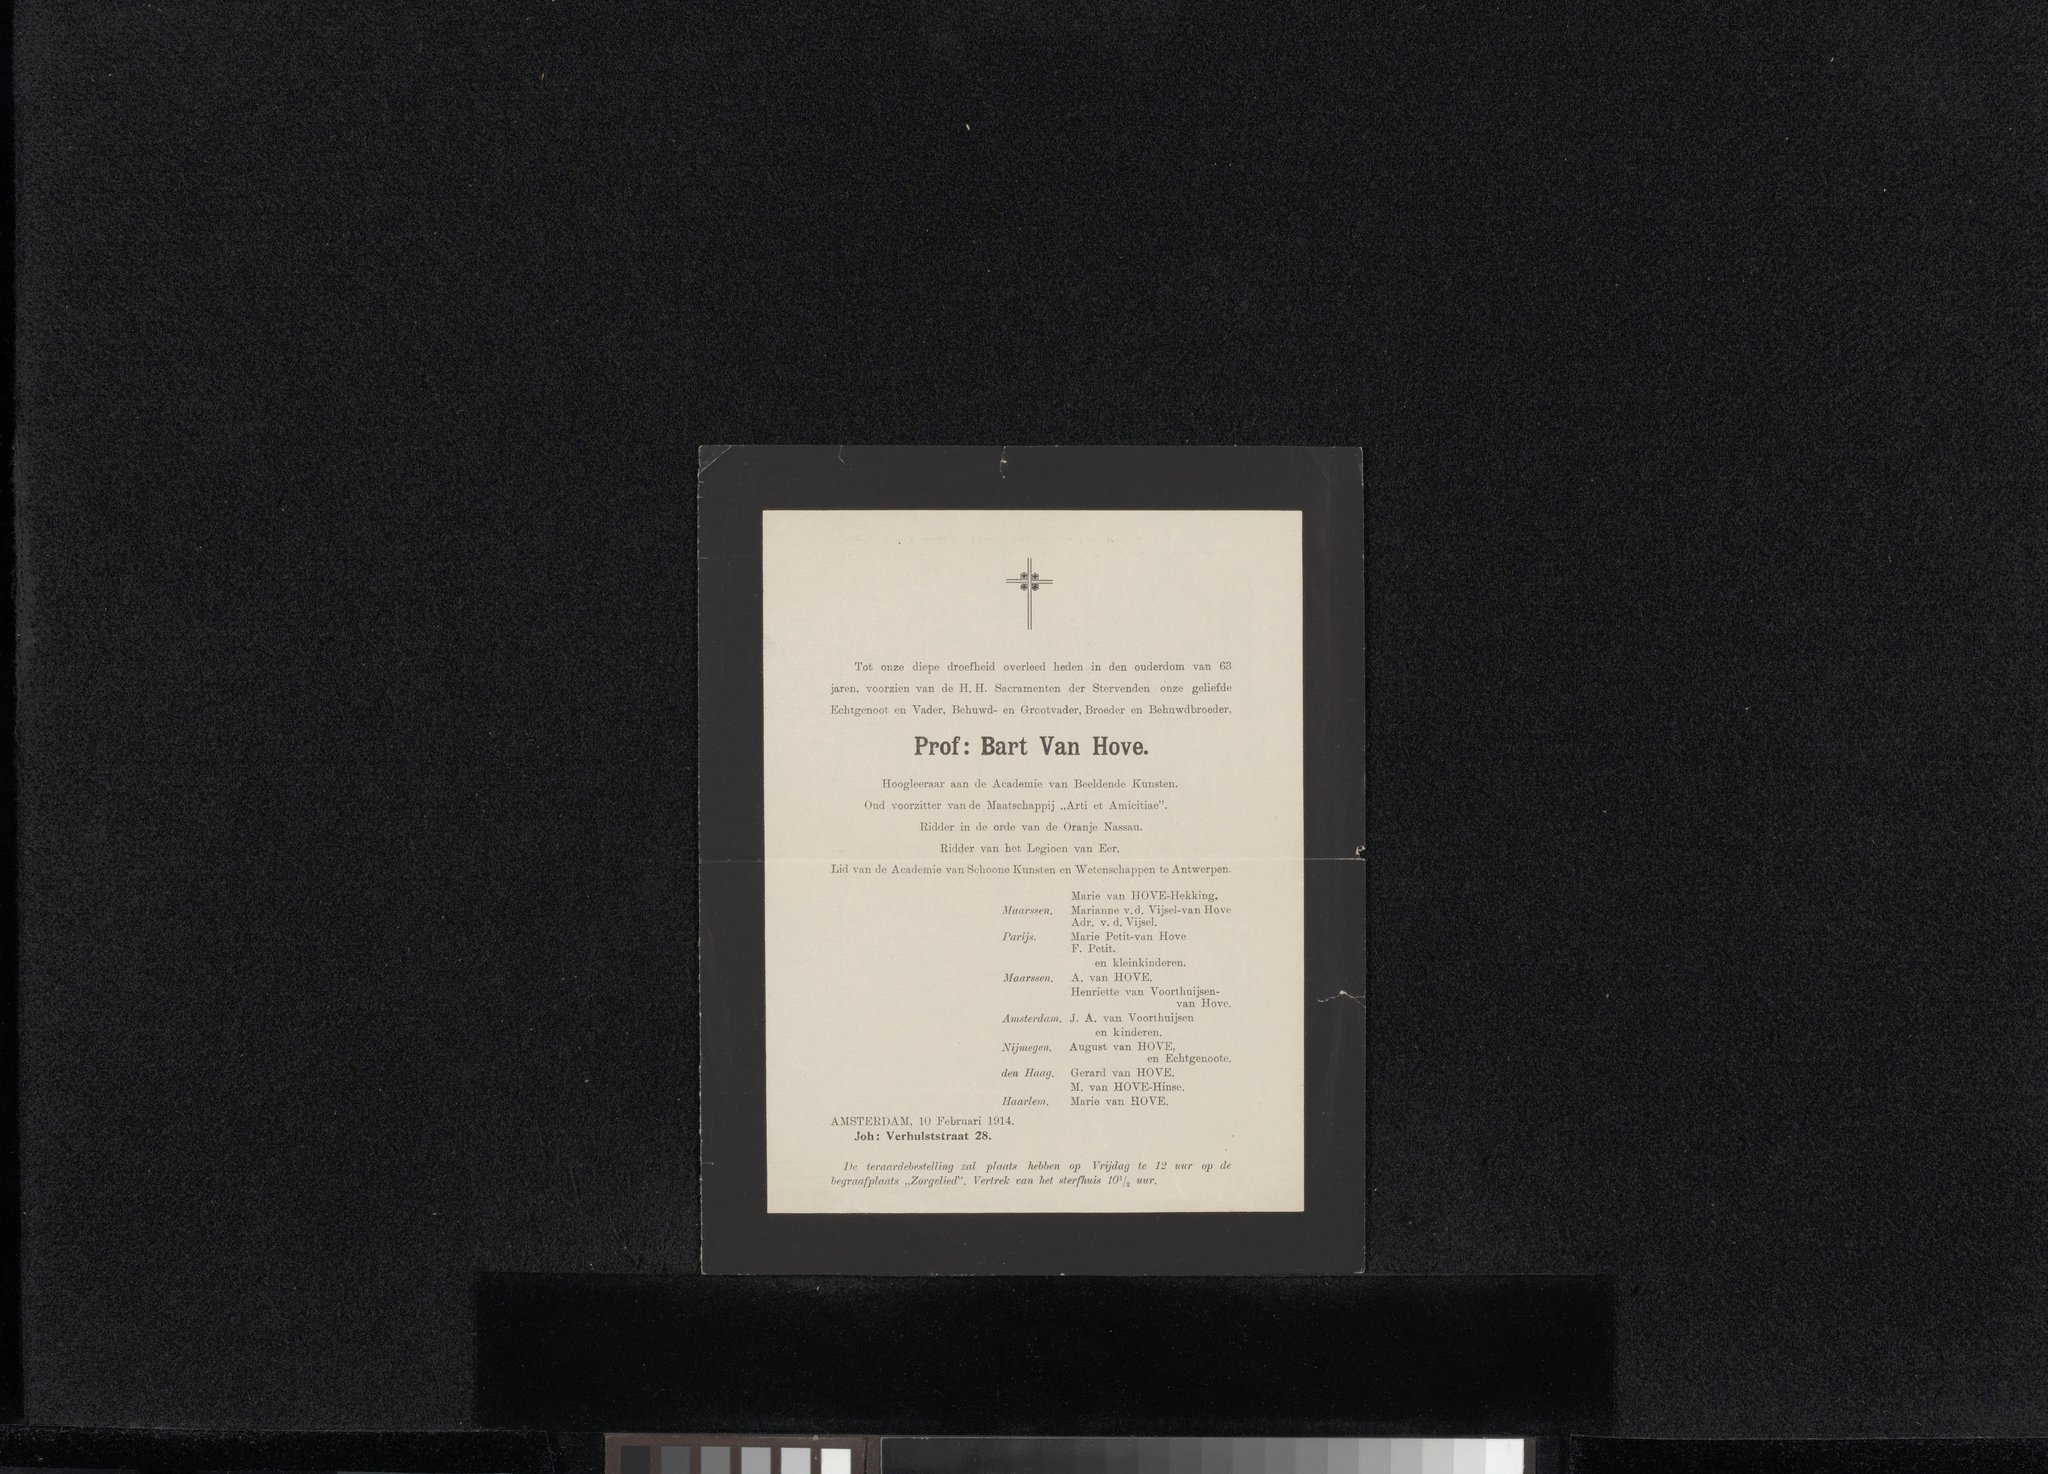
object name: overlijdensbericht, overlijdensadvertentie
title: Overlijdensbericht van Bart van Hove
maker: Anonymous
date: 1914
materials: paper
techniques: printing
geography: amsterdam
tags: sculptor, bart van hove